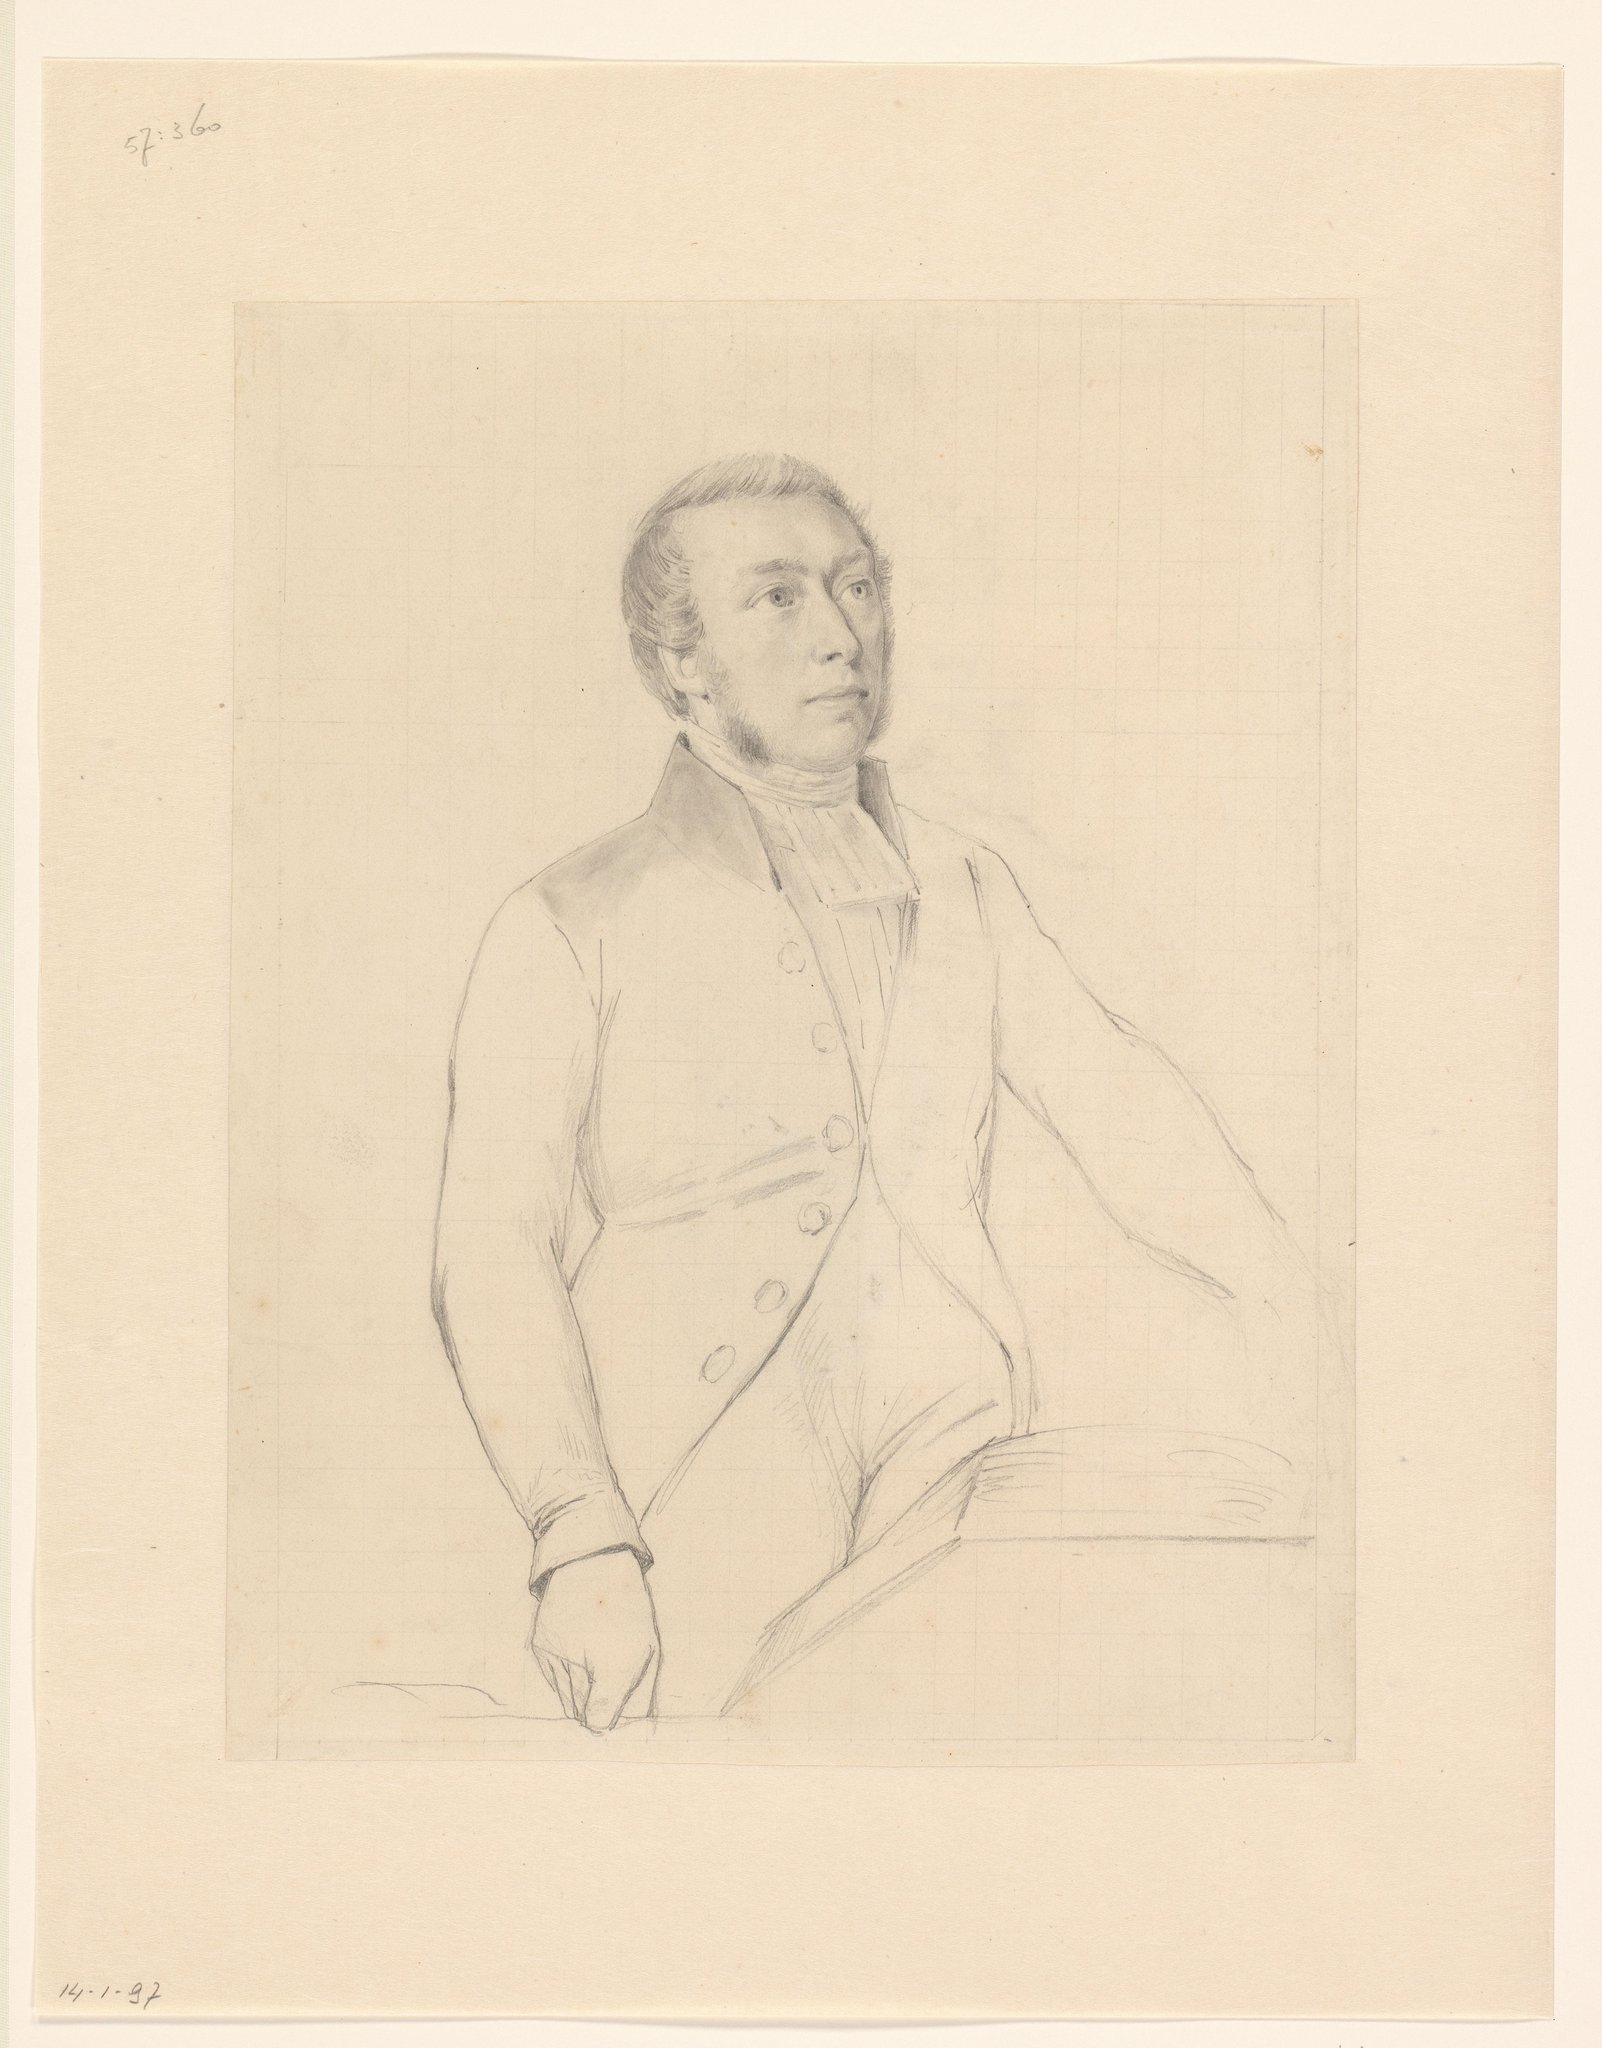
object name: drawing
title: Portret van een staande predikant op de preekstoel, voor een geopende Bijbel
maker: giovanni caramelli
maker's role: draughtsman, print maker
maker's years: 1816-1881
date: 1826-1881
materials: paper, pencil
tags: anonymous historical person portrayed alone, preaching (in general)